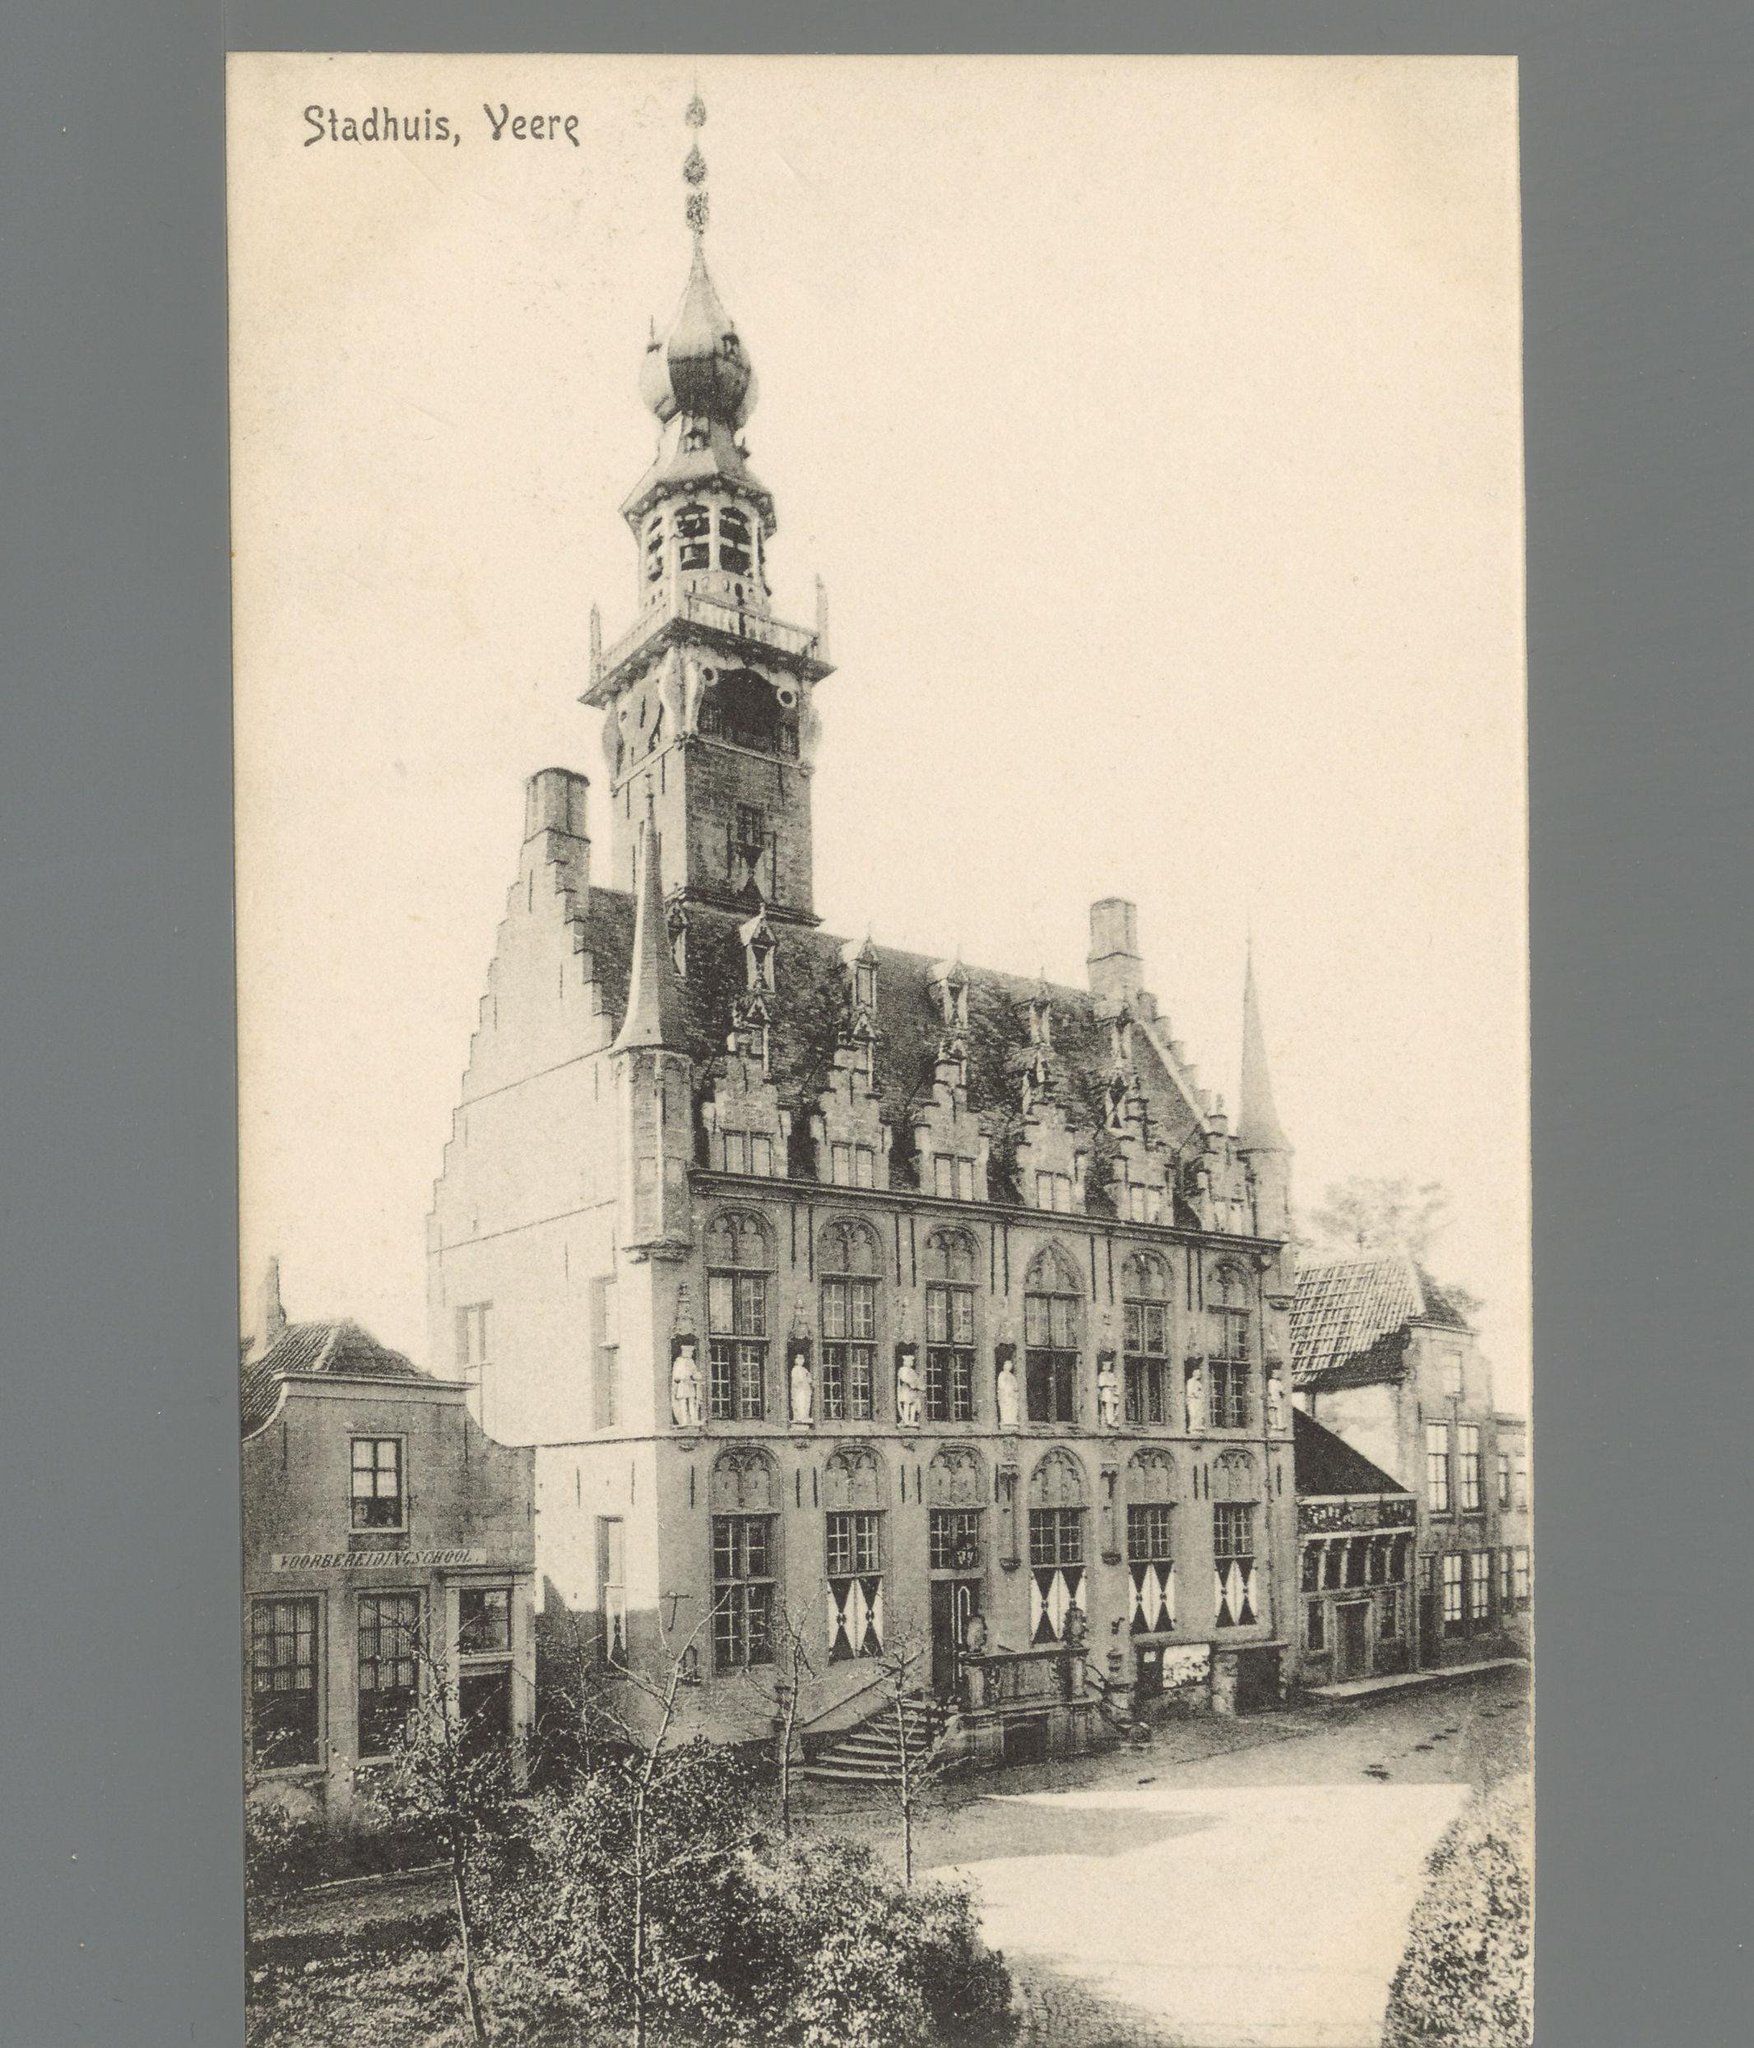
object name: photomechanical print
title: Stadhuis, Veere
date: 1905-1930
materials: cardboard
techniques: photograph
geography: veere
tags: townhall